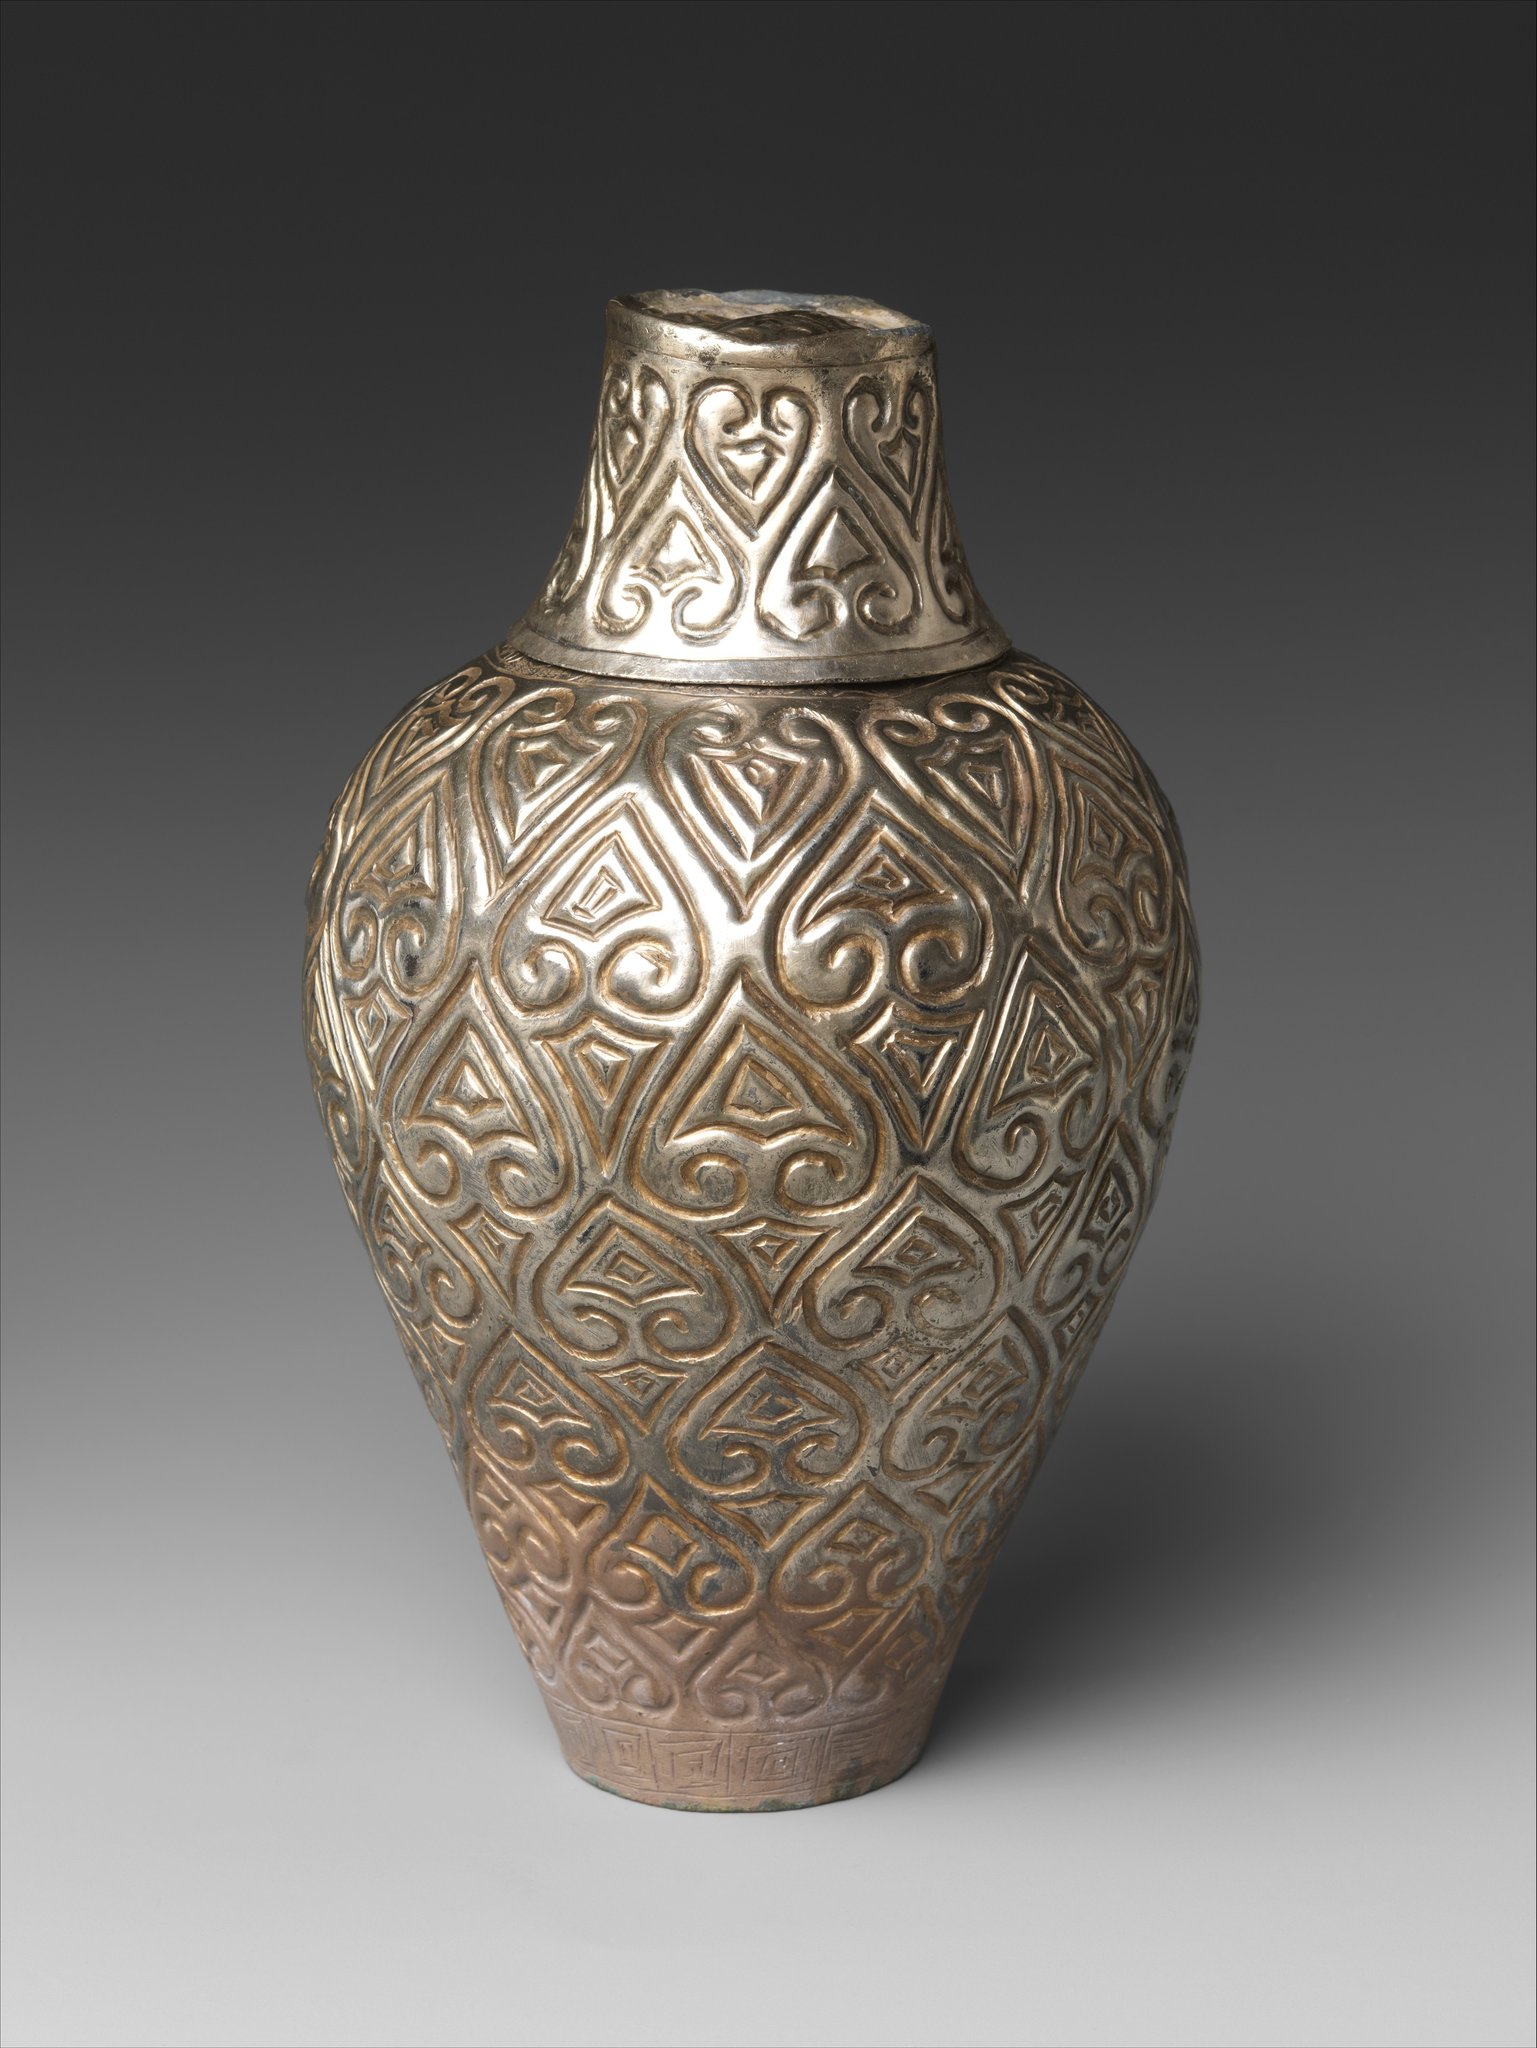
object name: bottle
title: Covered bottle with cloud scrolls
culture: chinese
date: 1301-1400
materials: silver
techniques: incising